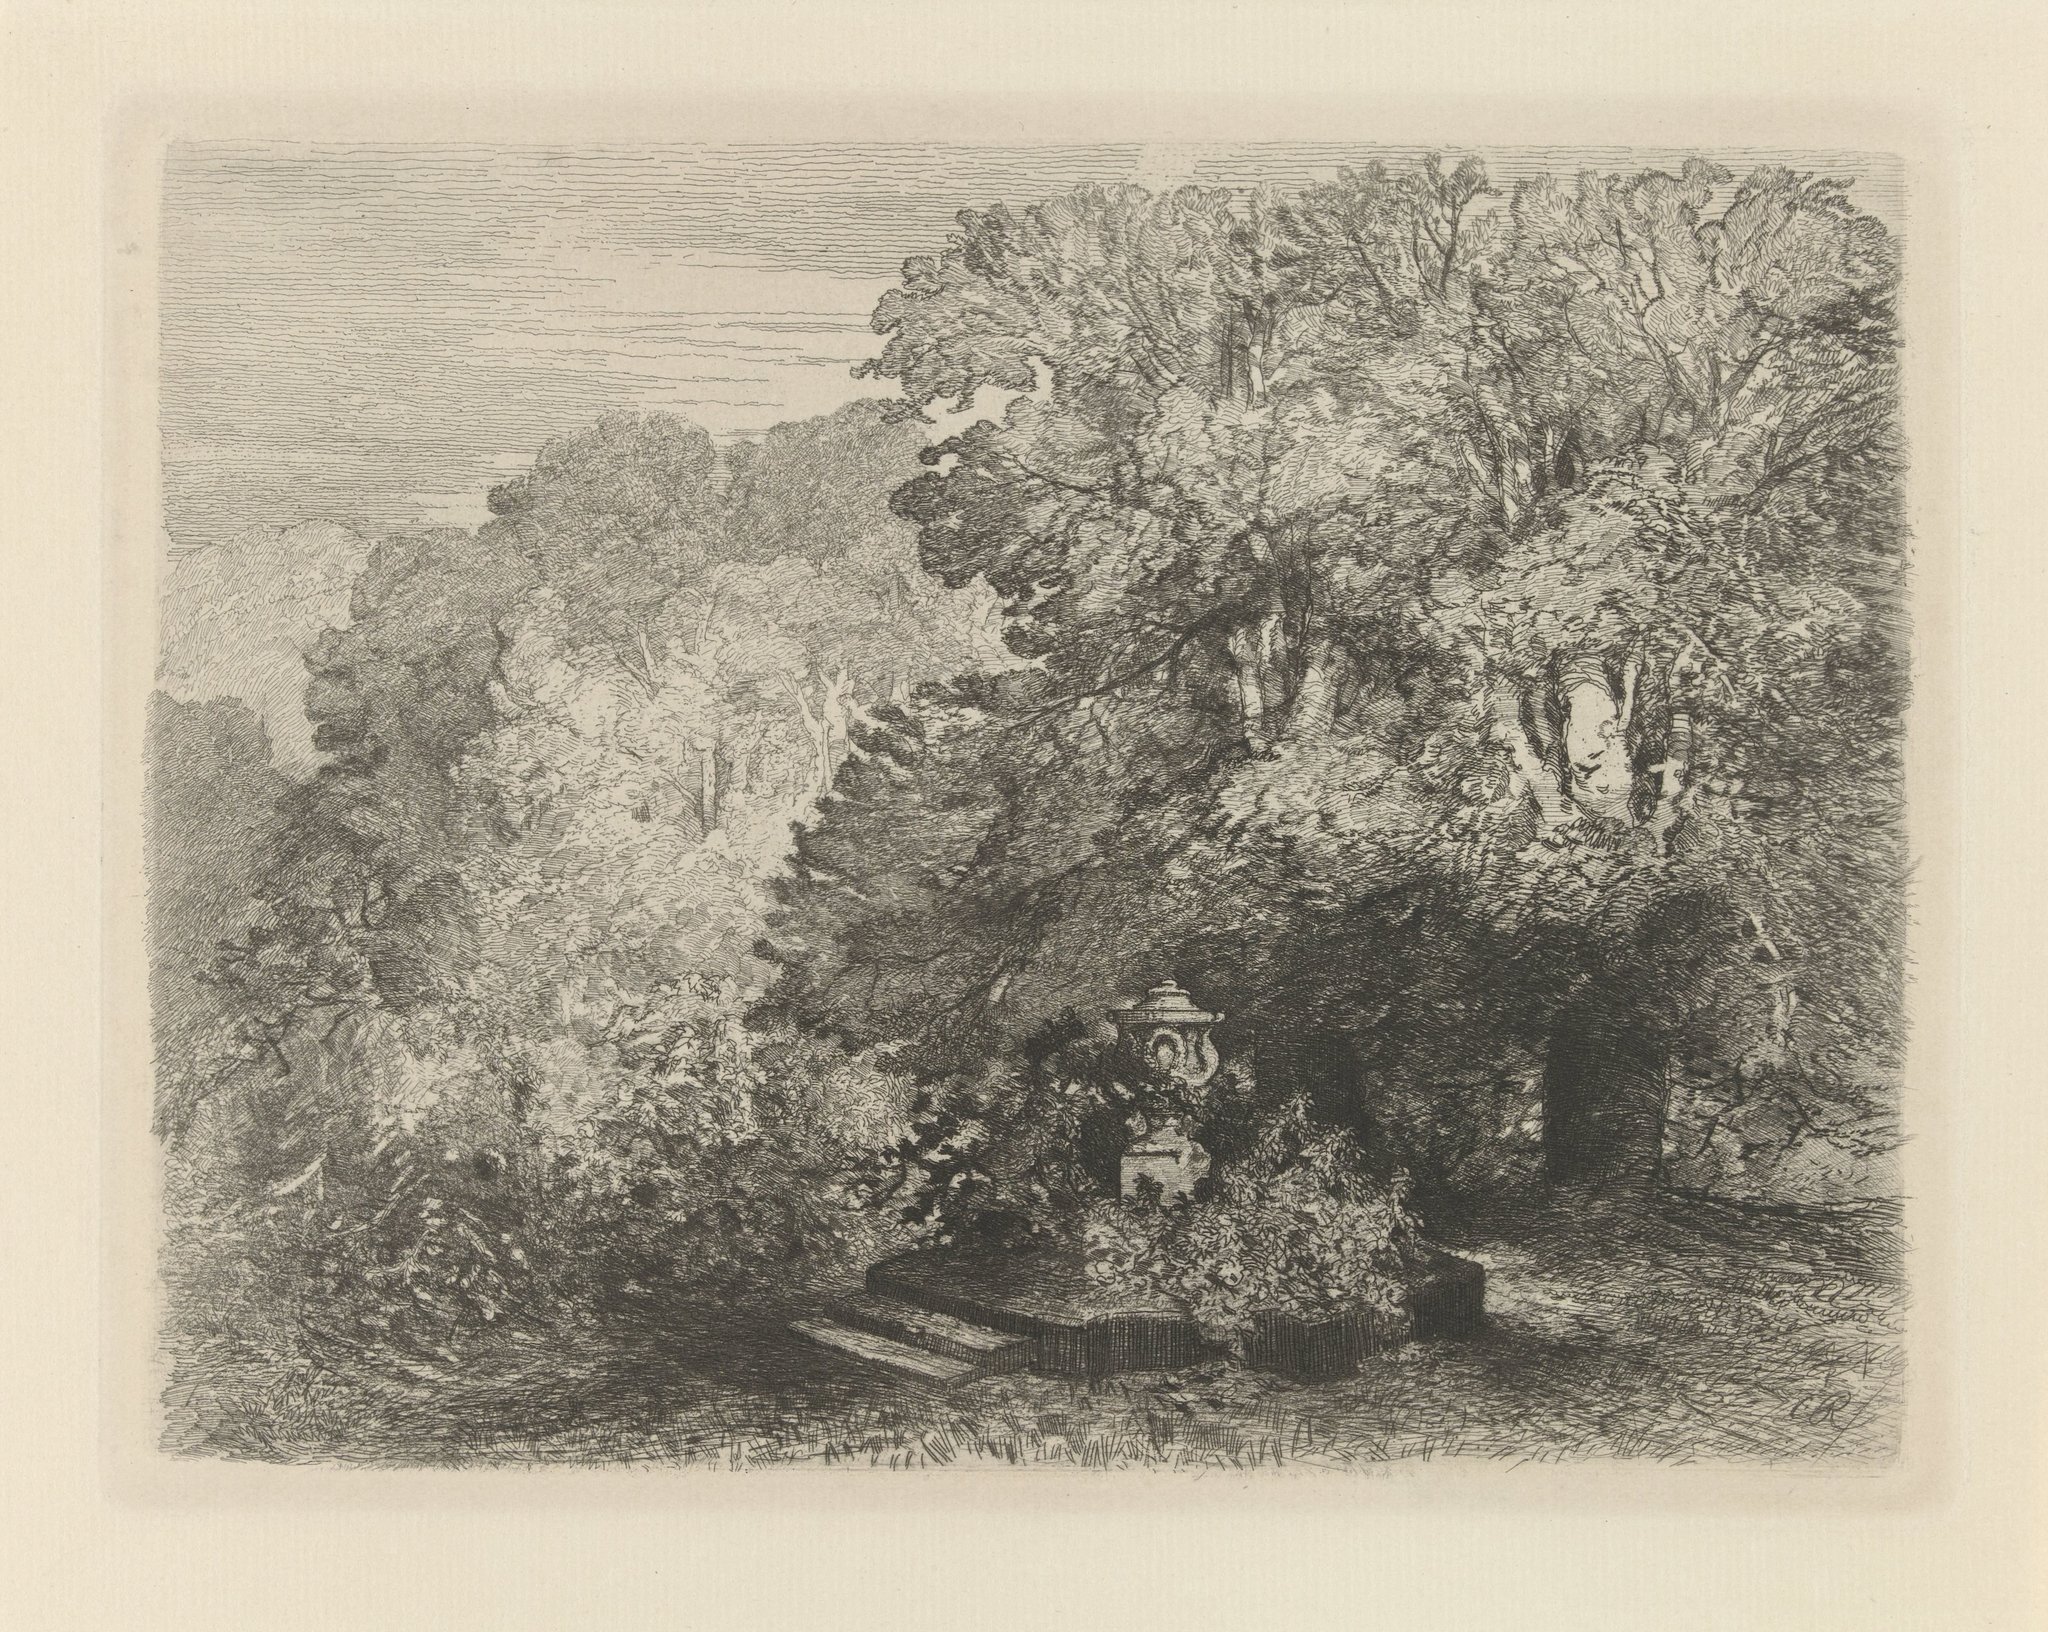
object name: print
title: Vaas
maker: charles rochussen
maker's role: draughtsman, painter, print maker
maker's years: 1814-1894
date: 1824-1879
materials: paper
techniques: drypoint, etching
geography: netherlands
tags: garden vase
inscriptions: collector's mark: Lugt 2228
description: Op een verhoging staat een vaas, omgeven door struiken. Rechts twee grote bomen.